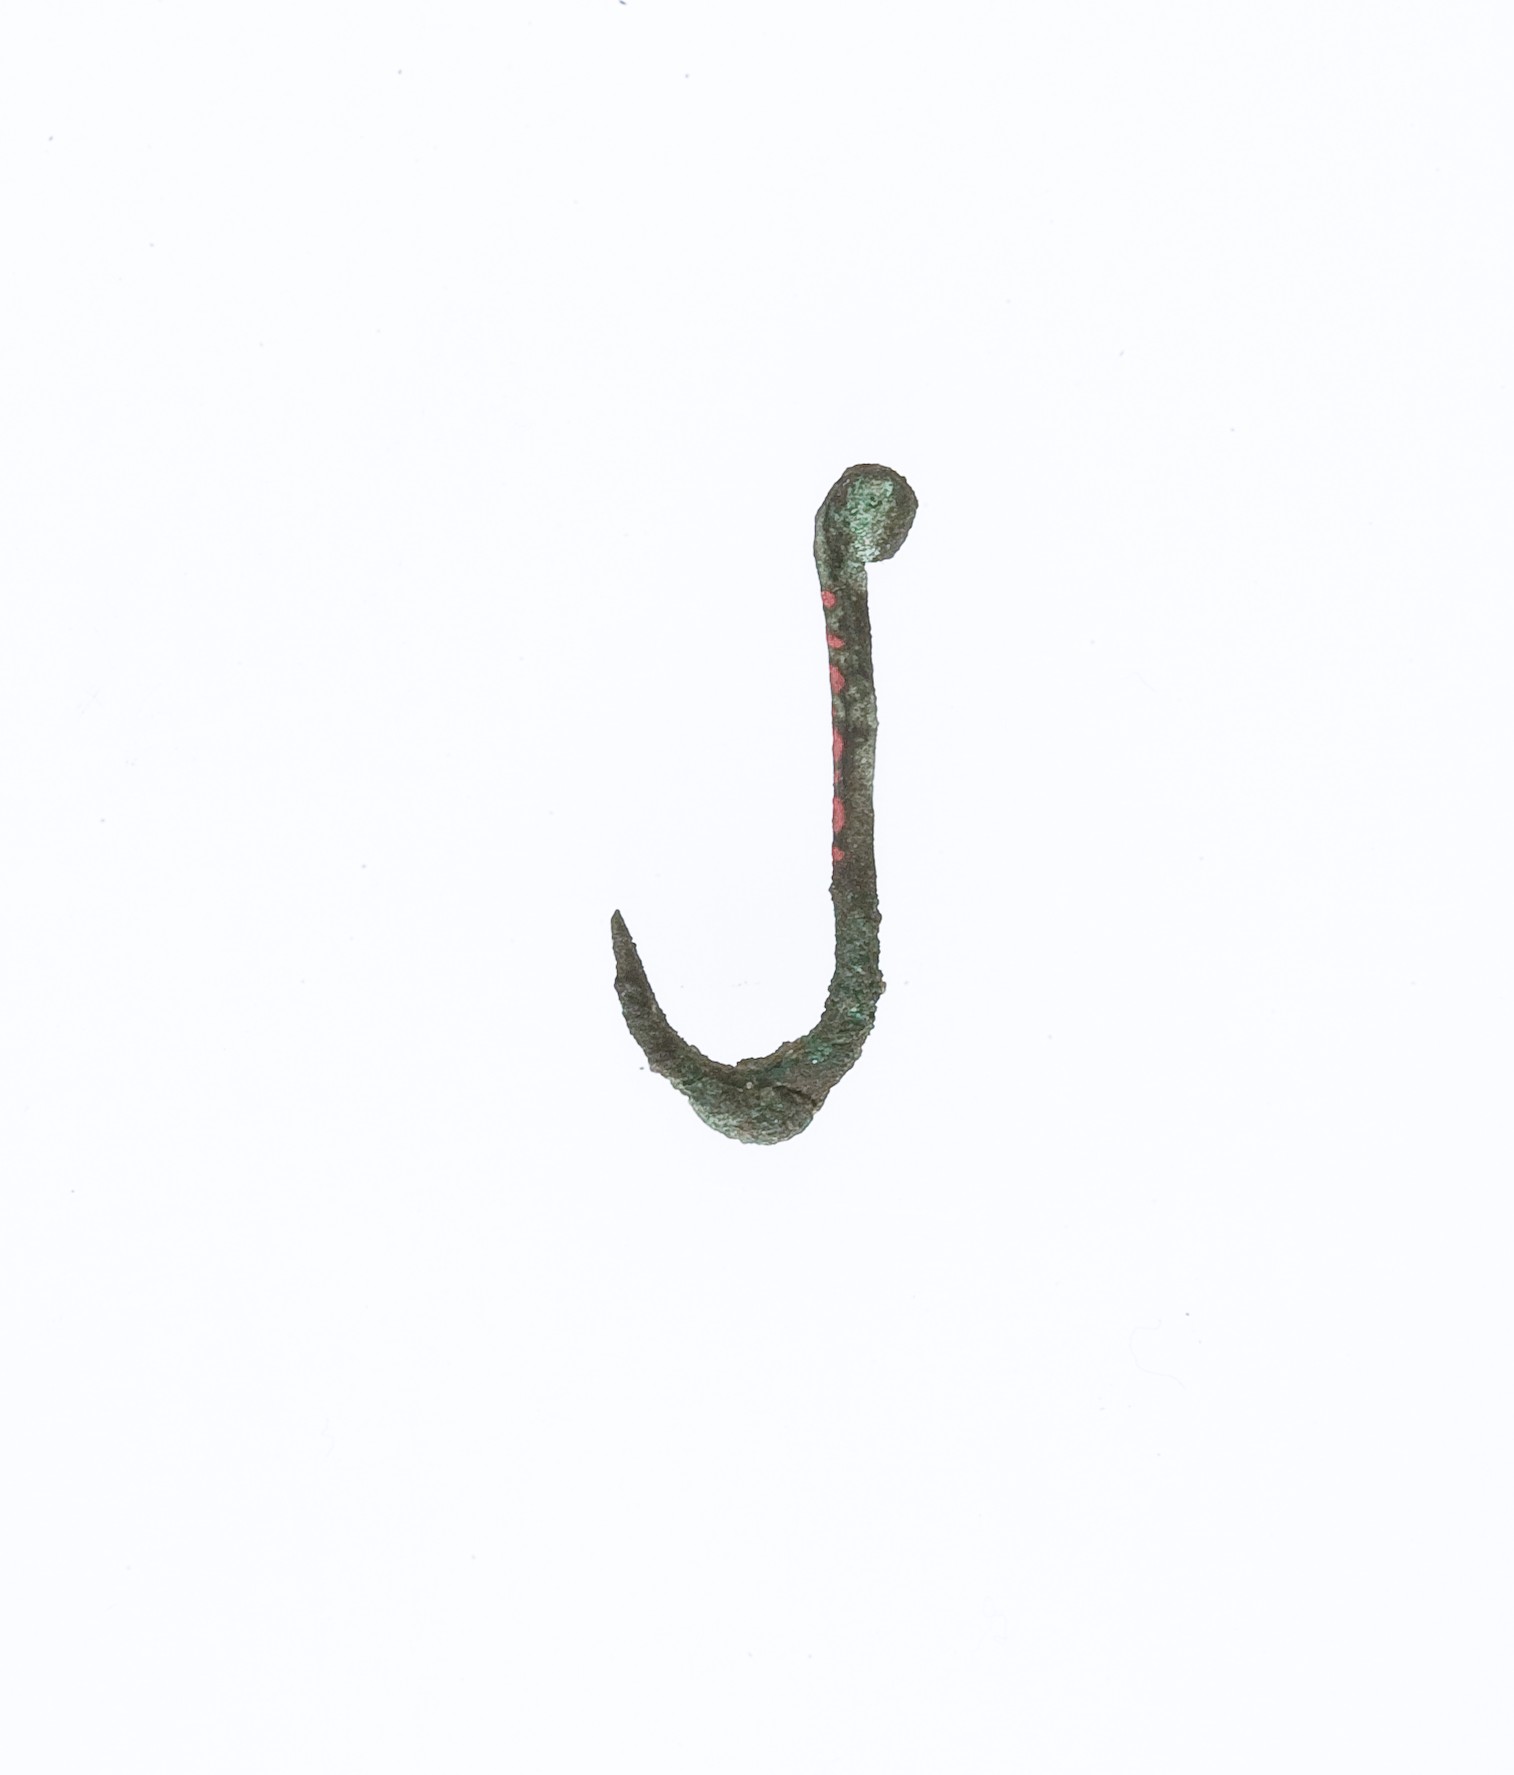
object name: fish hook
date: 1295-1070 BCE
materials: bronze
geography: egypt